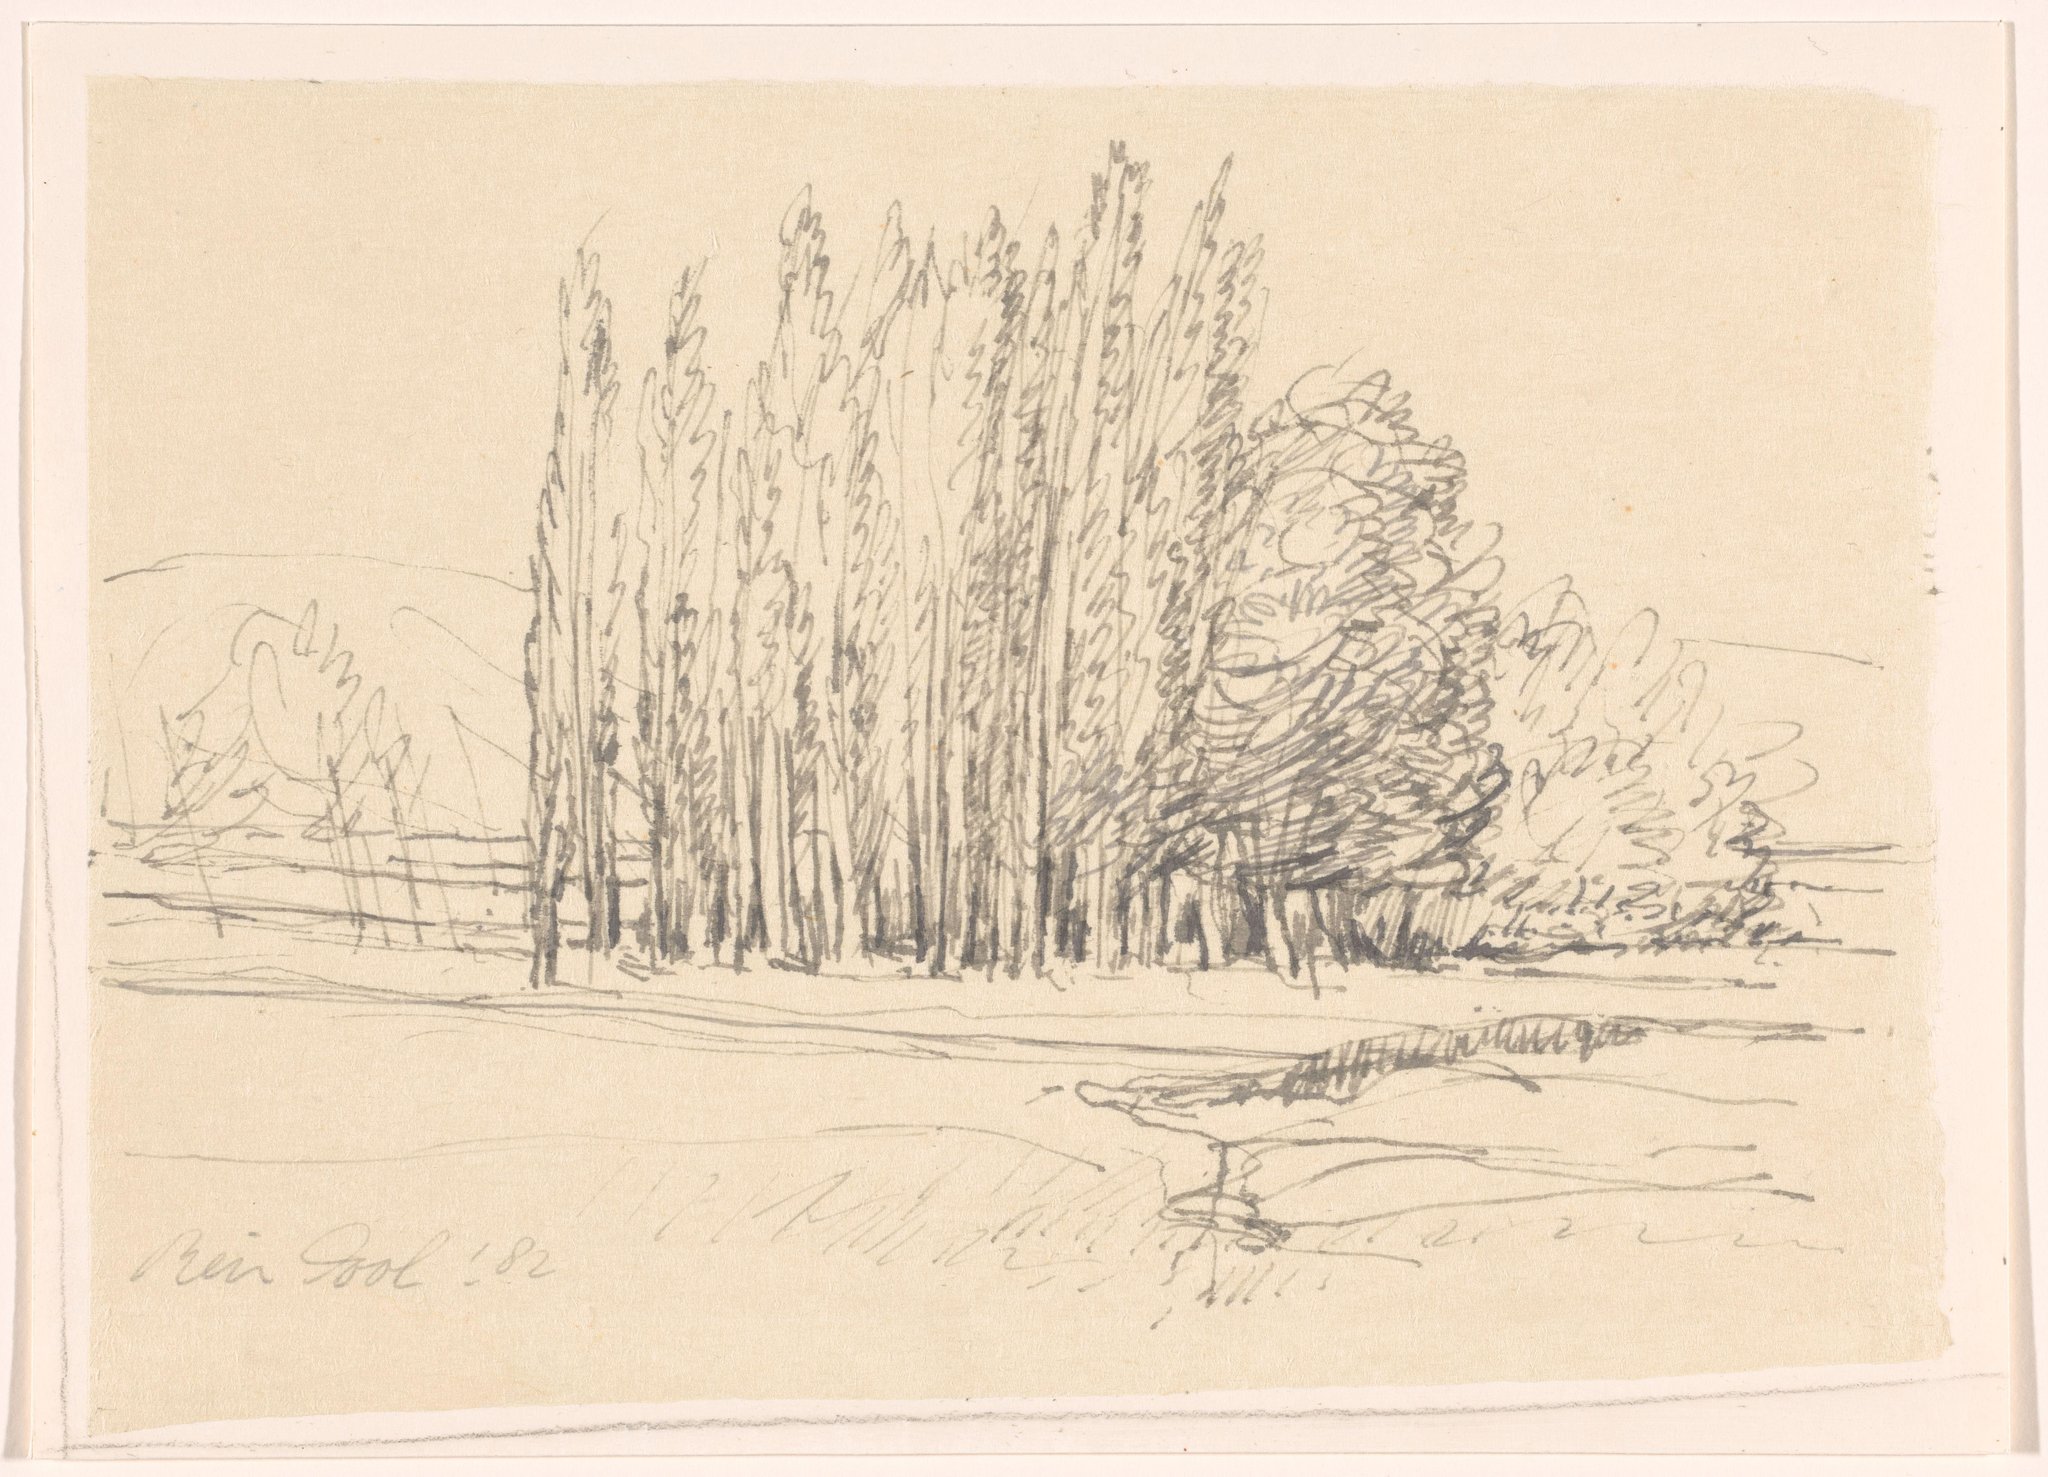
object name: drawing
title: Populieren, Frankrijk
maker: rein dool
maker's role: draughtsman, painter, print maker, sculptor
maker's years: 1933-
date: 1982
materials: ink, paper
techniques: pen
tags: france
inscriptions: signature and date